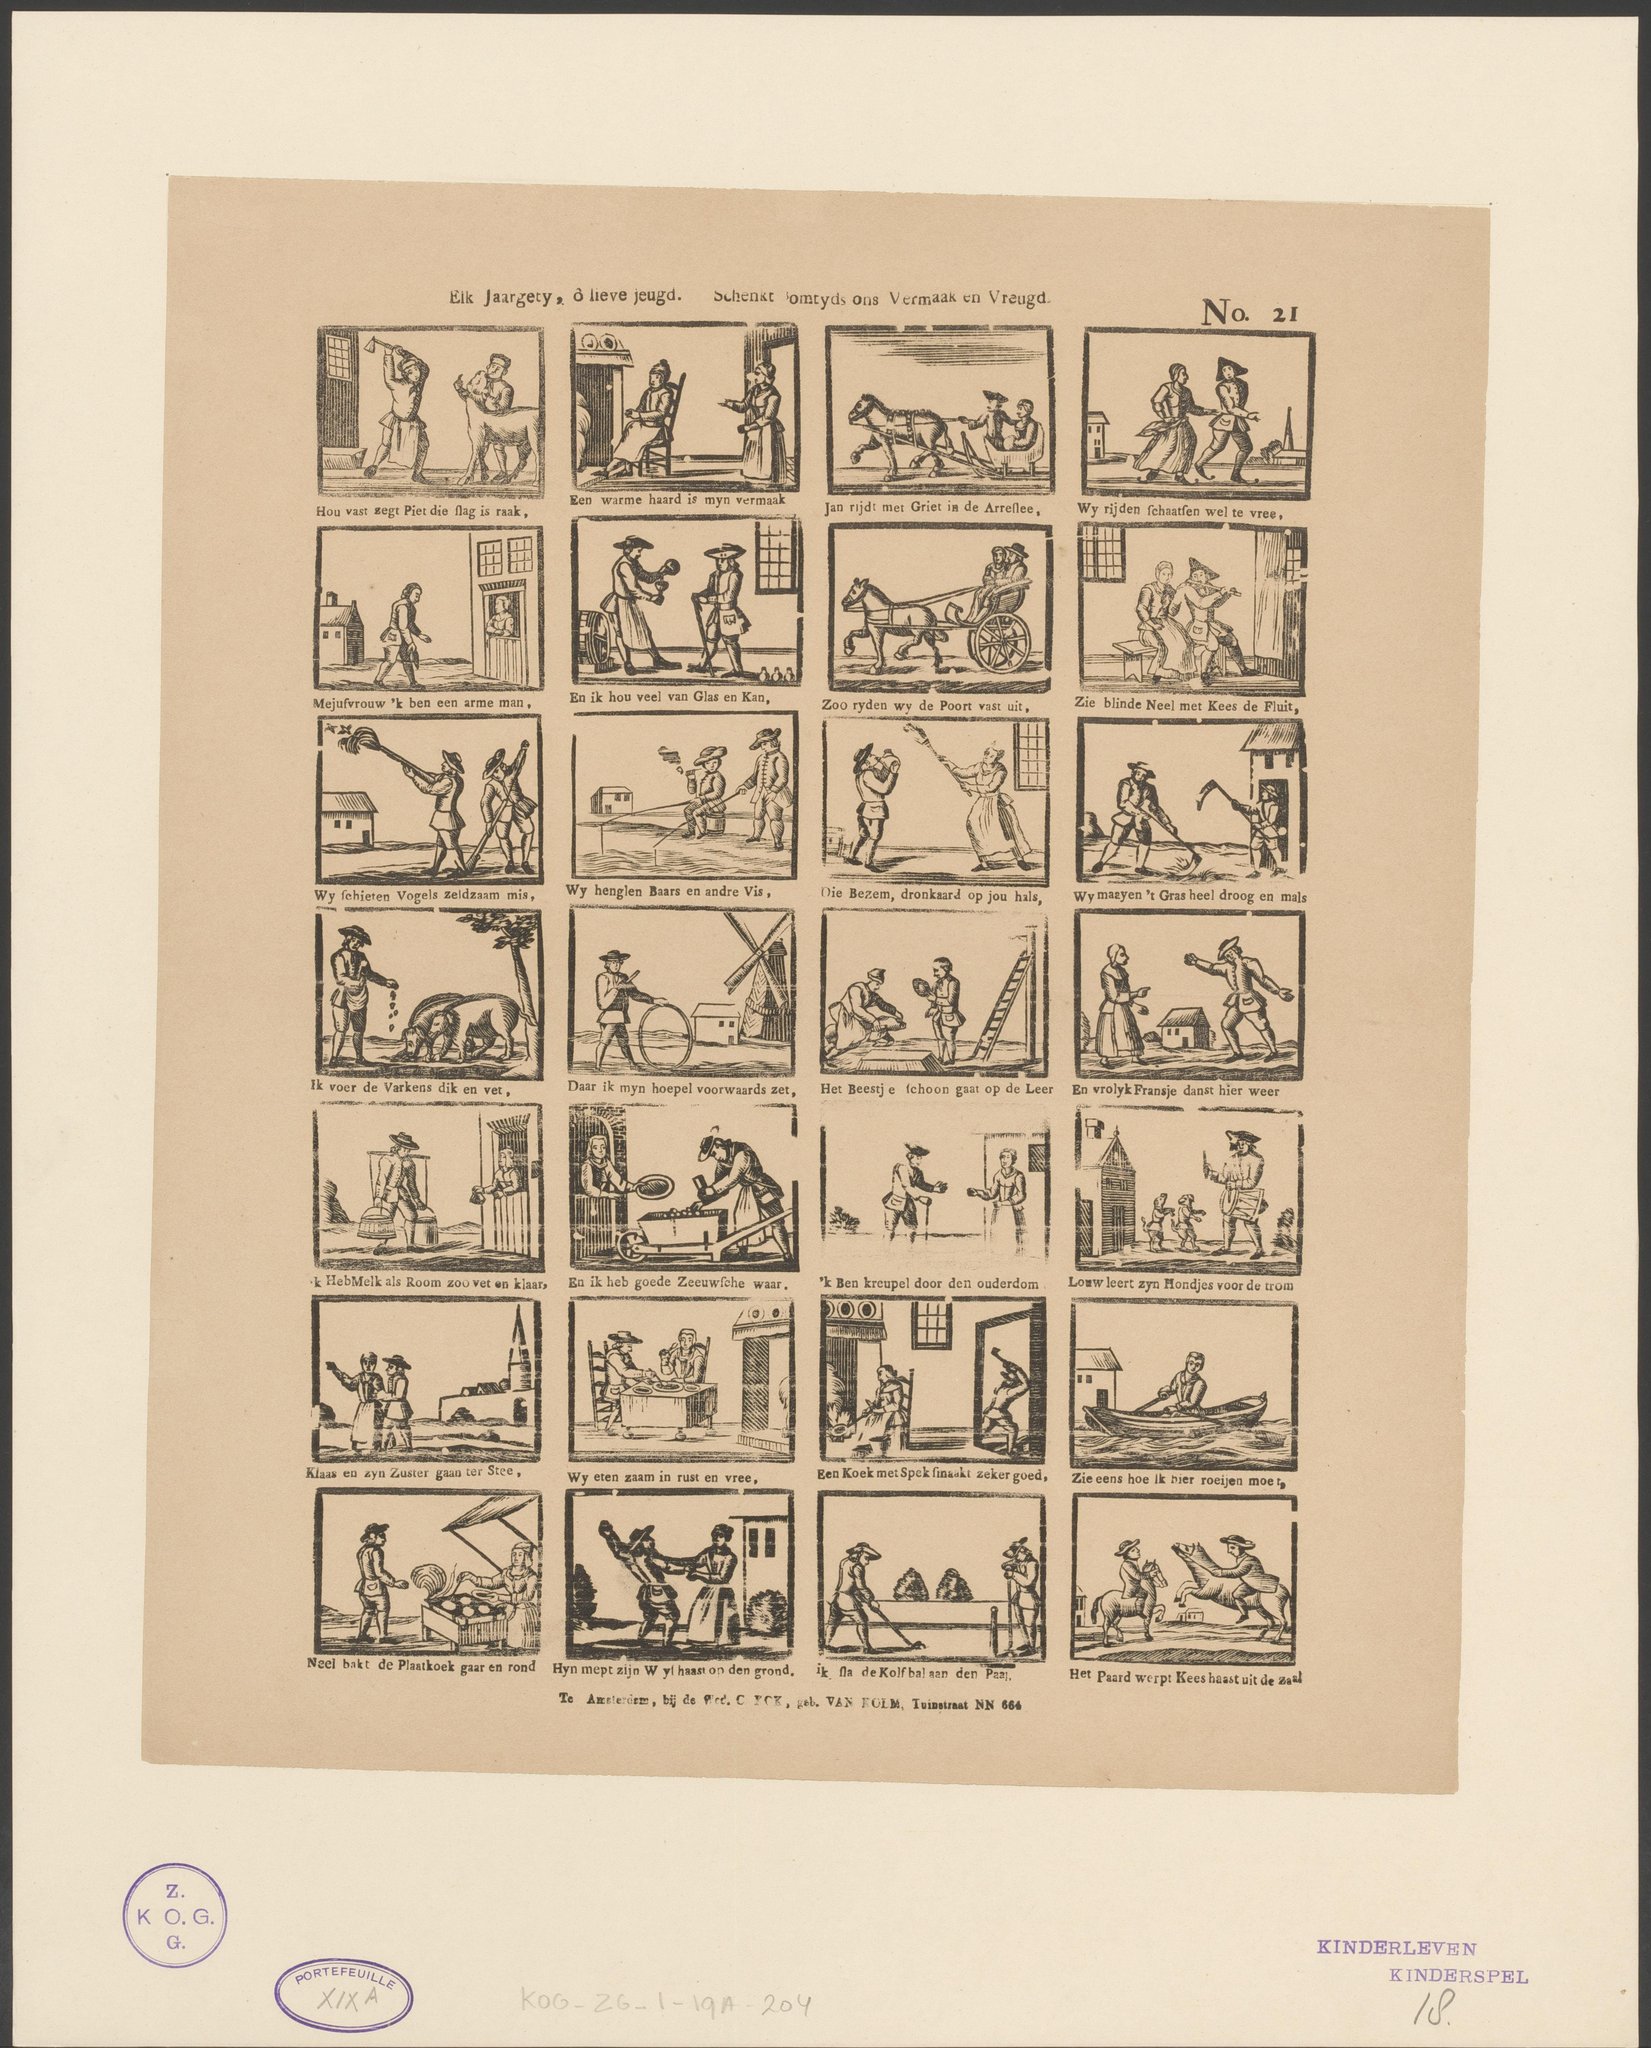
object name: print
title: Arbeid en vermaak tijdens de verschillende jaargetijden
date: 1842-1866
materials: paper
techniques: letterpress printing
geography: amsterdam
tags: harvest, children's games and plays, farmers, the four seasons of the year ~ human activities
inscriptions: stamp, collector's mark: Lugt 1641, stamp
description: Achtentwintig voorstellingen van landelijke taferelen tijdens de verschillende jaargetijden. Onder elke afbeelding een onderschrift. Genummerd rechtsboven: No. 21. Onderwerpsrubrieken binnen de Atlas Zeden en Gewoonten: Zeden en Gewoonten in Engeren Zin, Des menschen beging, midden en einde, Kinderleven – Kinderspel en Kinderprenten.